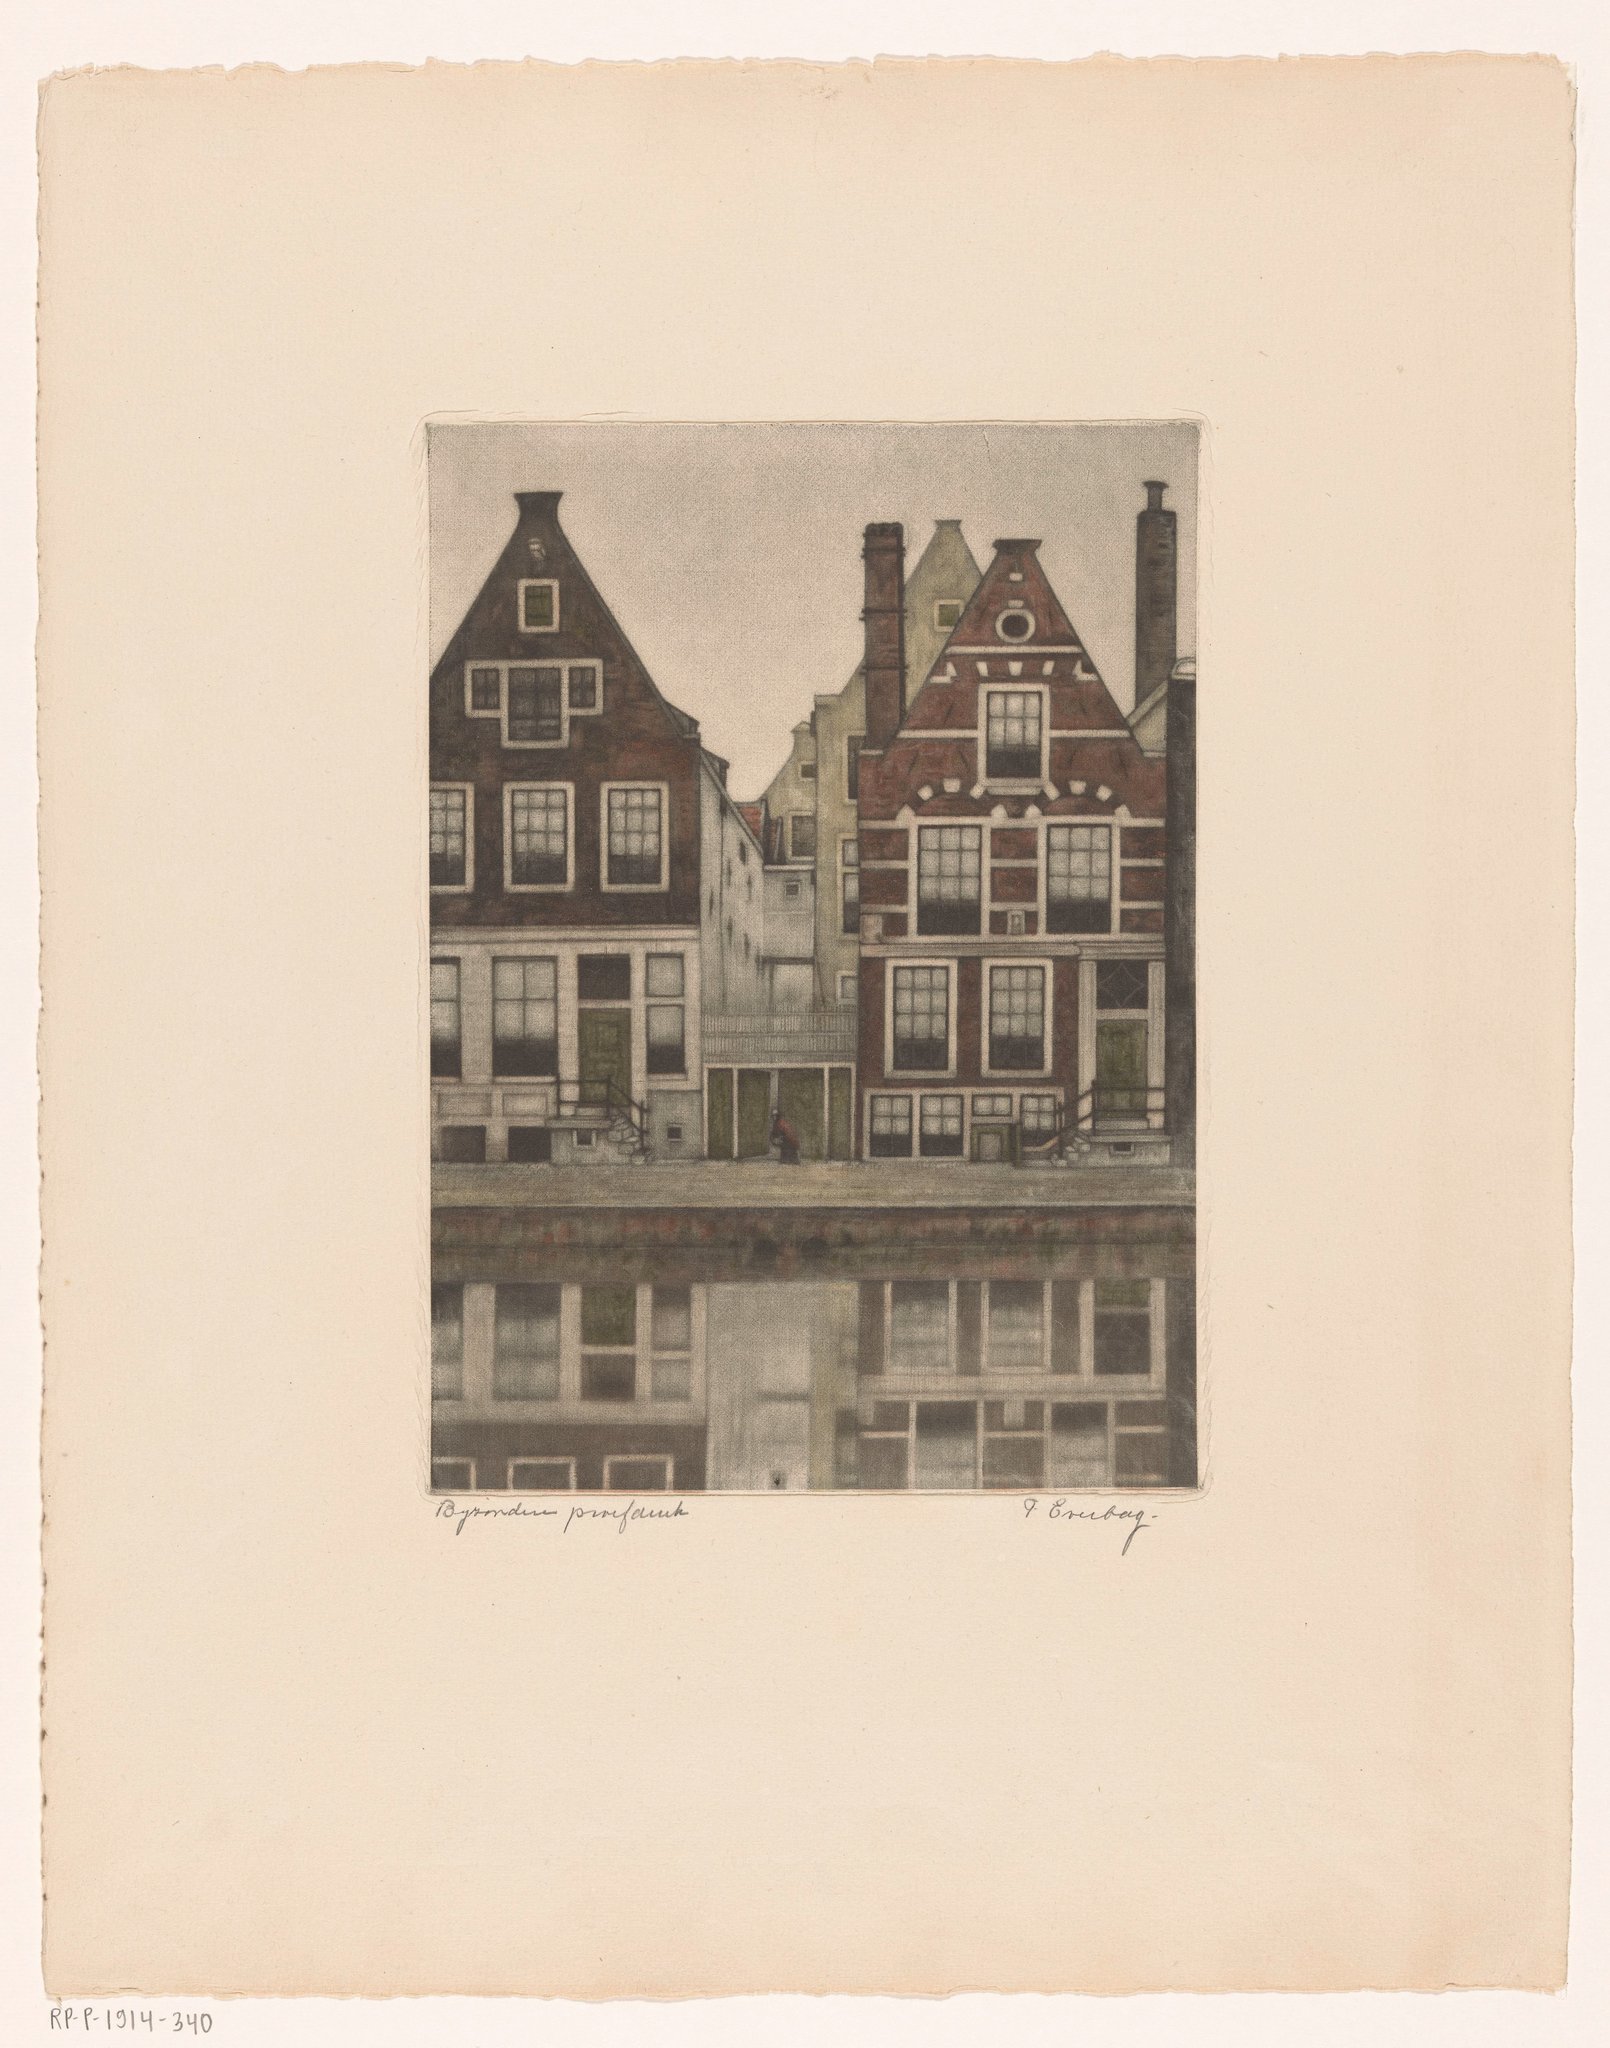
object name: print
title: Huizen aan de Groenburgwal in Amsterdam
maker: frans everbag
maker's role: draughtsman, print maker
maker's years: 1877-1947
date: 1903-1914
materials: paper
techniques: color mezzotint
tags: urban housing, canals, waters (in city)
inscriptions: collector's mark: Lugt 2233